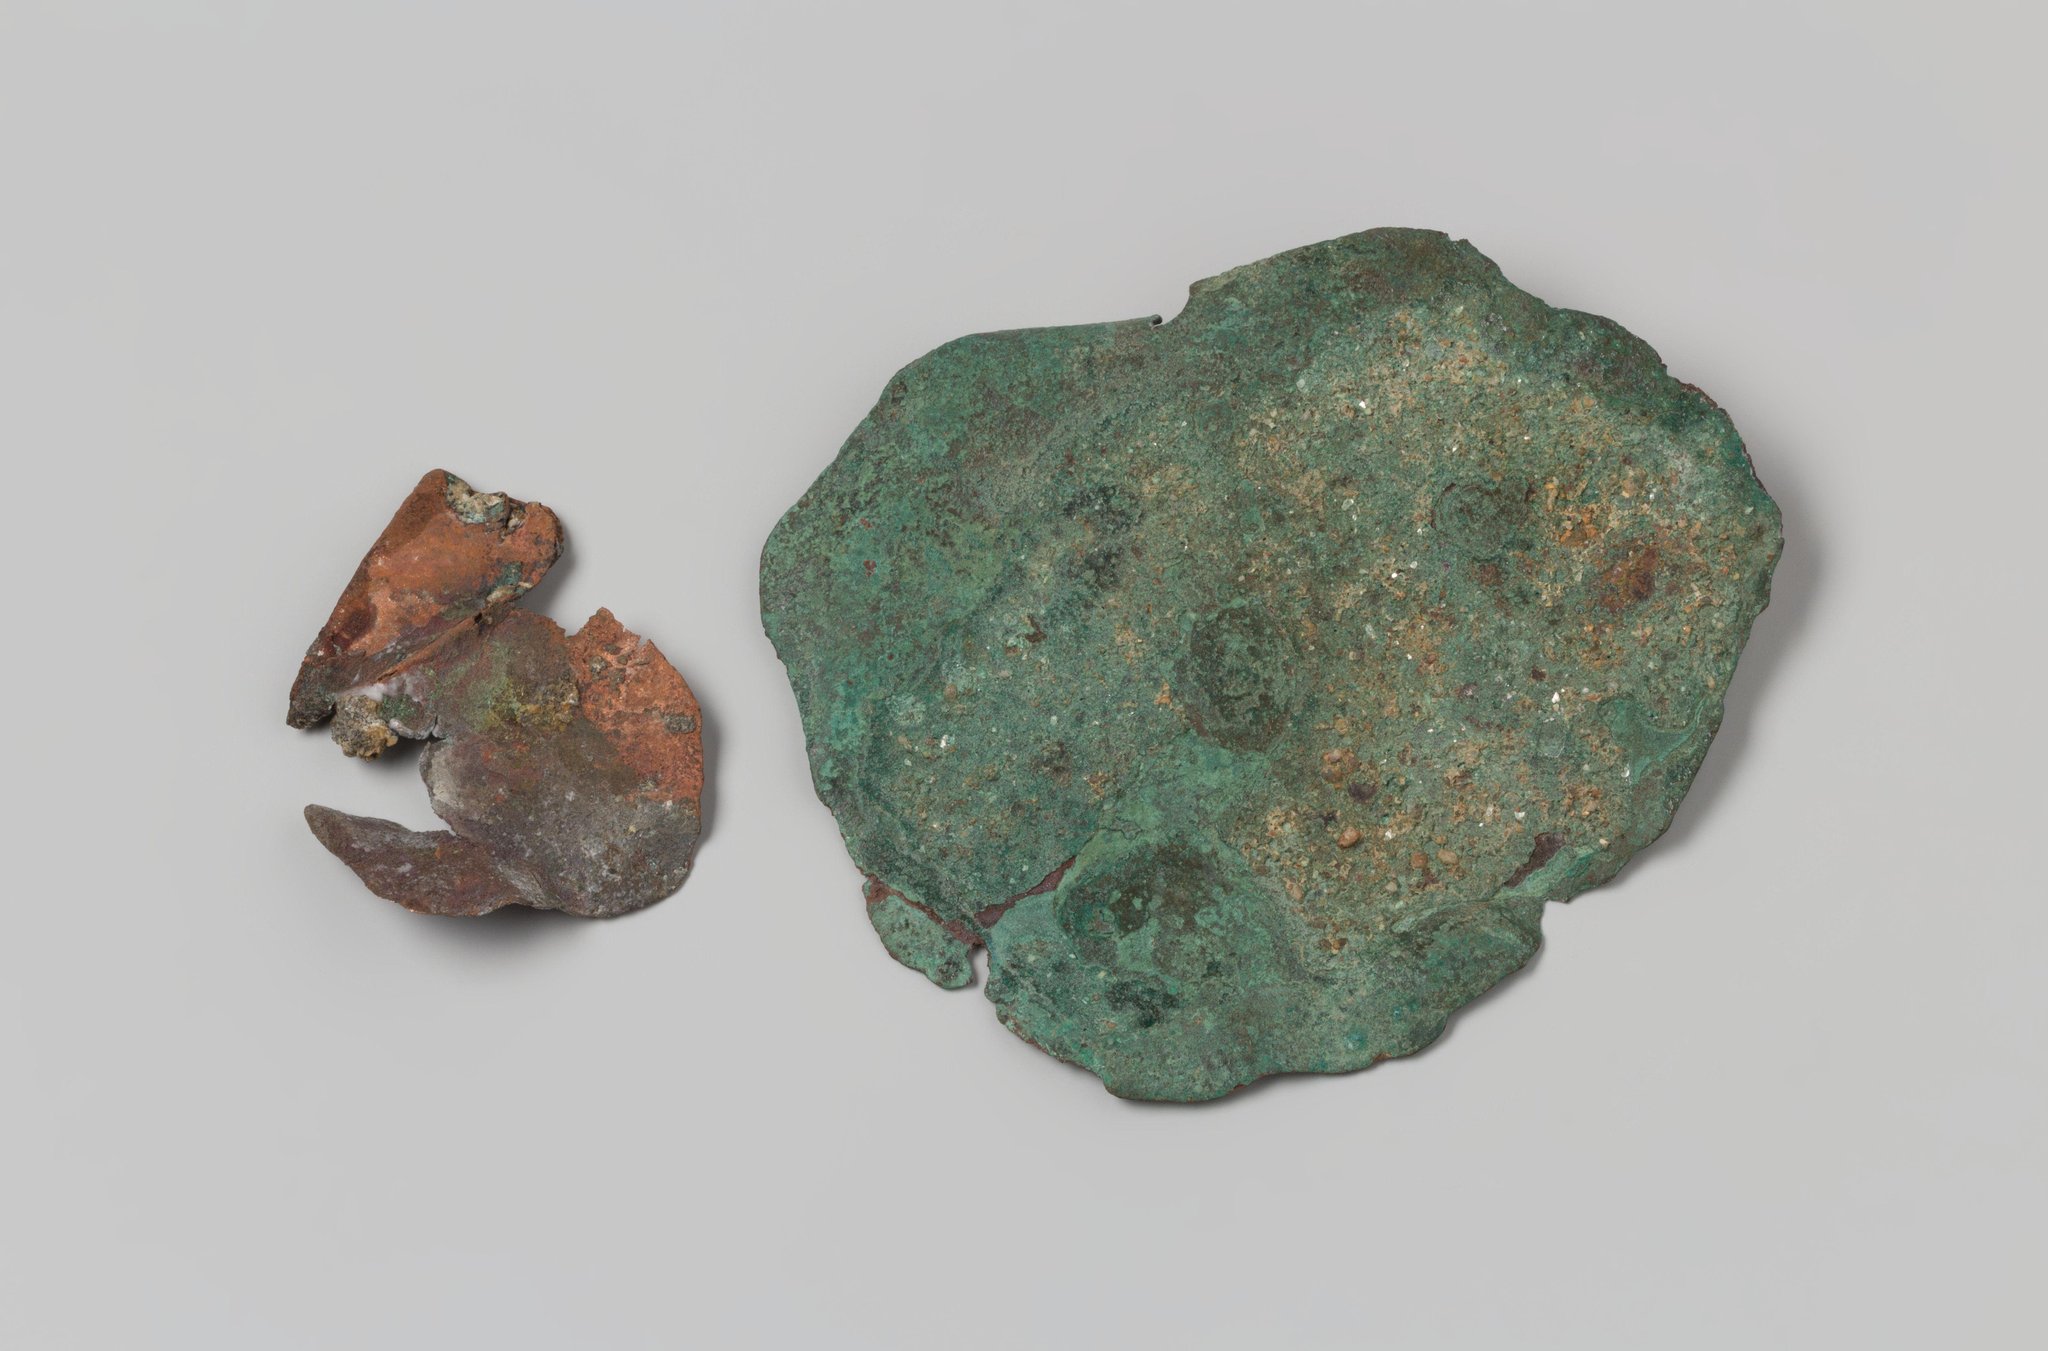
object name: scheepswrakvondst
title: Fragmenten van koper uit het wrak van de Oost-Indiëvaarder Hollandia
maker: Anonymous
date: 1700-1743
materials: copper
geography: netherlands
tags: verenigde oostindische compagnie, hollandia (schip), annet